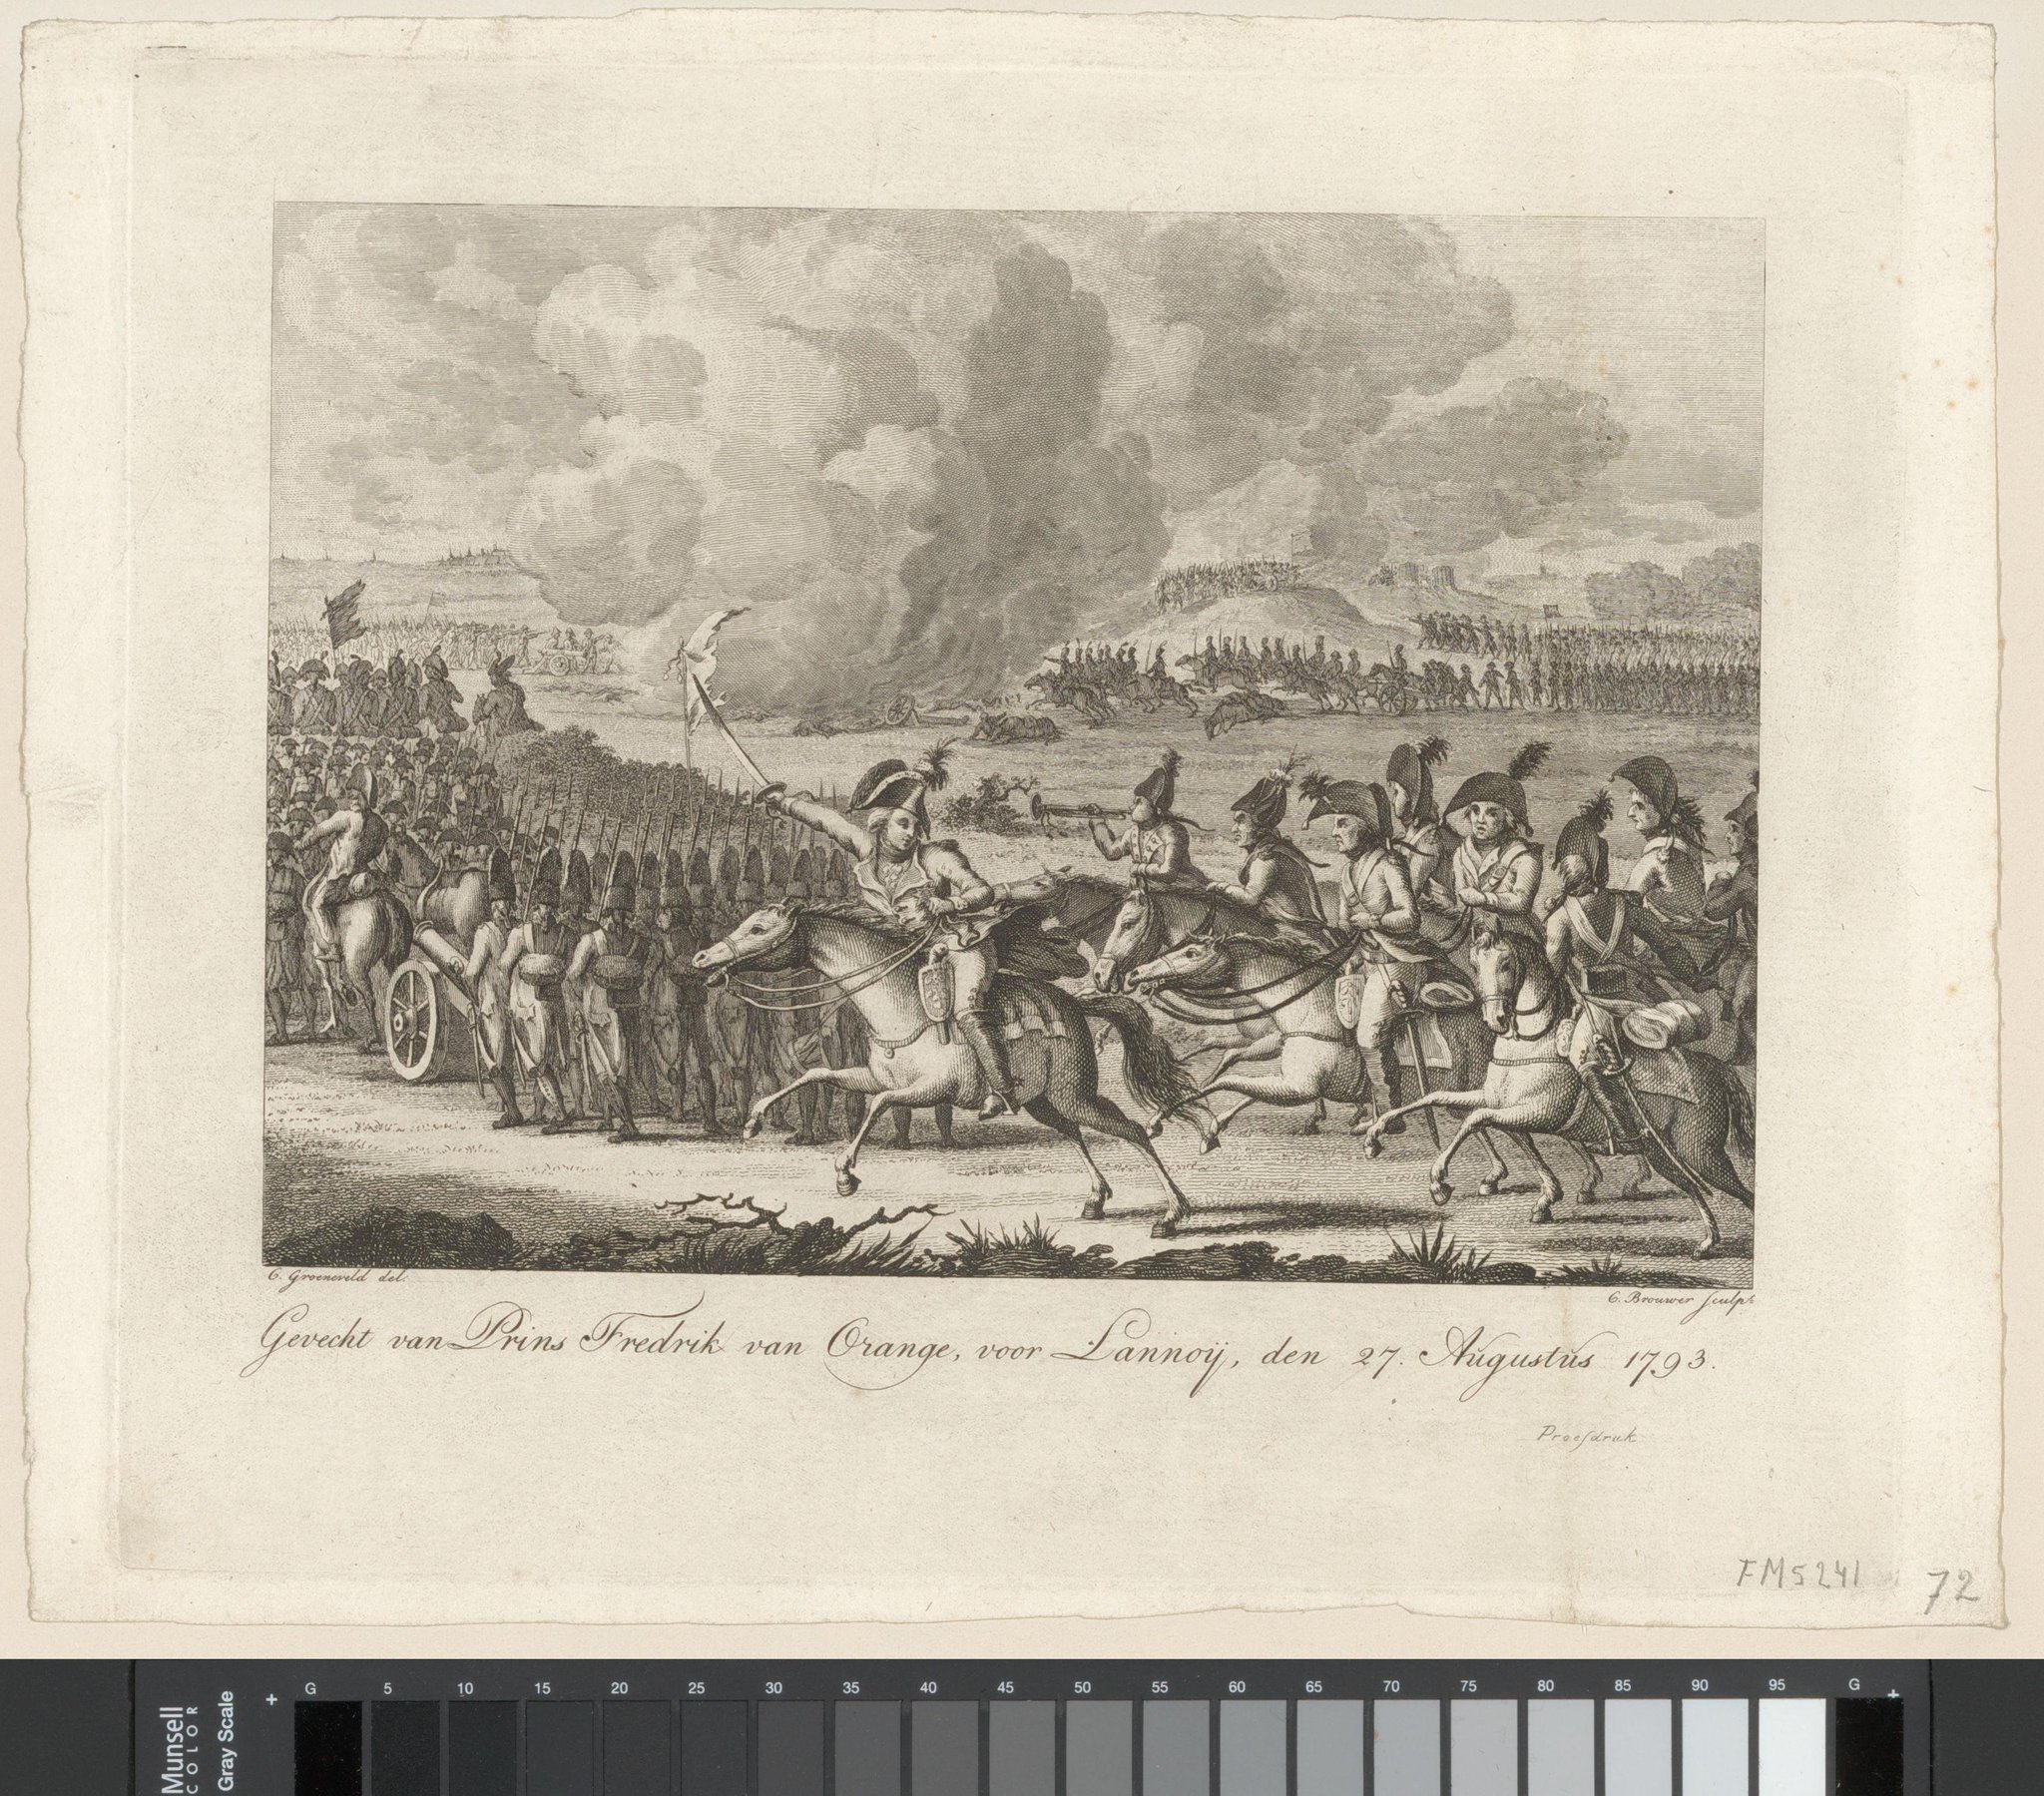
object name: print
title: Gevecht van Prins Frederik van Orange, voor Lannoy, den 27. Augustus 1793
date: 1802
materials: paper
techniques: engraving, etching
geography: northern netherlands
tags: the hague, willem george frederik (prins van oranje-nassau), battle (+ land forces)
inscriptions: collector's mark: Lugt 1641, collector's mark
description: Gebruikt als illustratie in: J.P. van Ginkel, Het leven van Willem George Fredrik, Prince van Orange. Rotterdam: J.P. van Ginkel, 1802-1803.